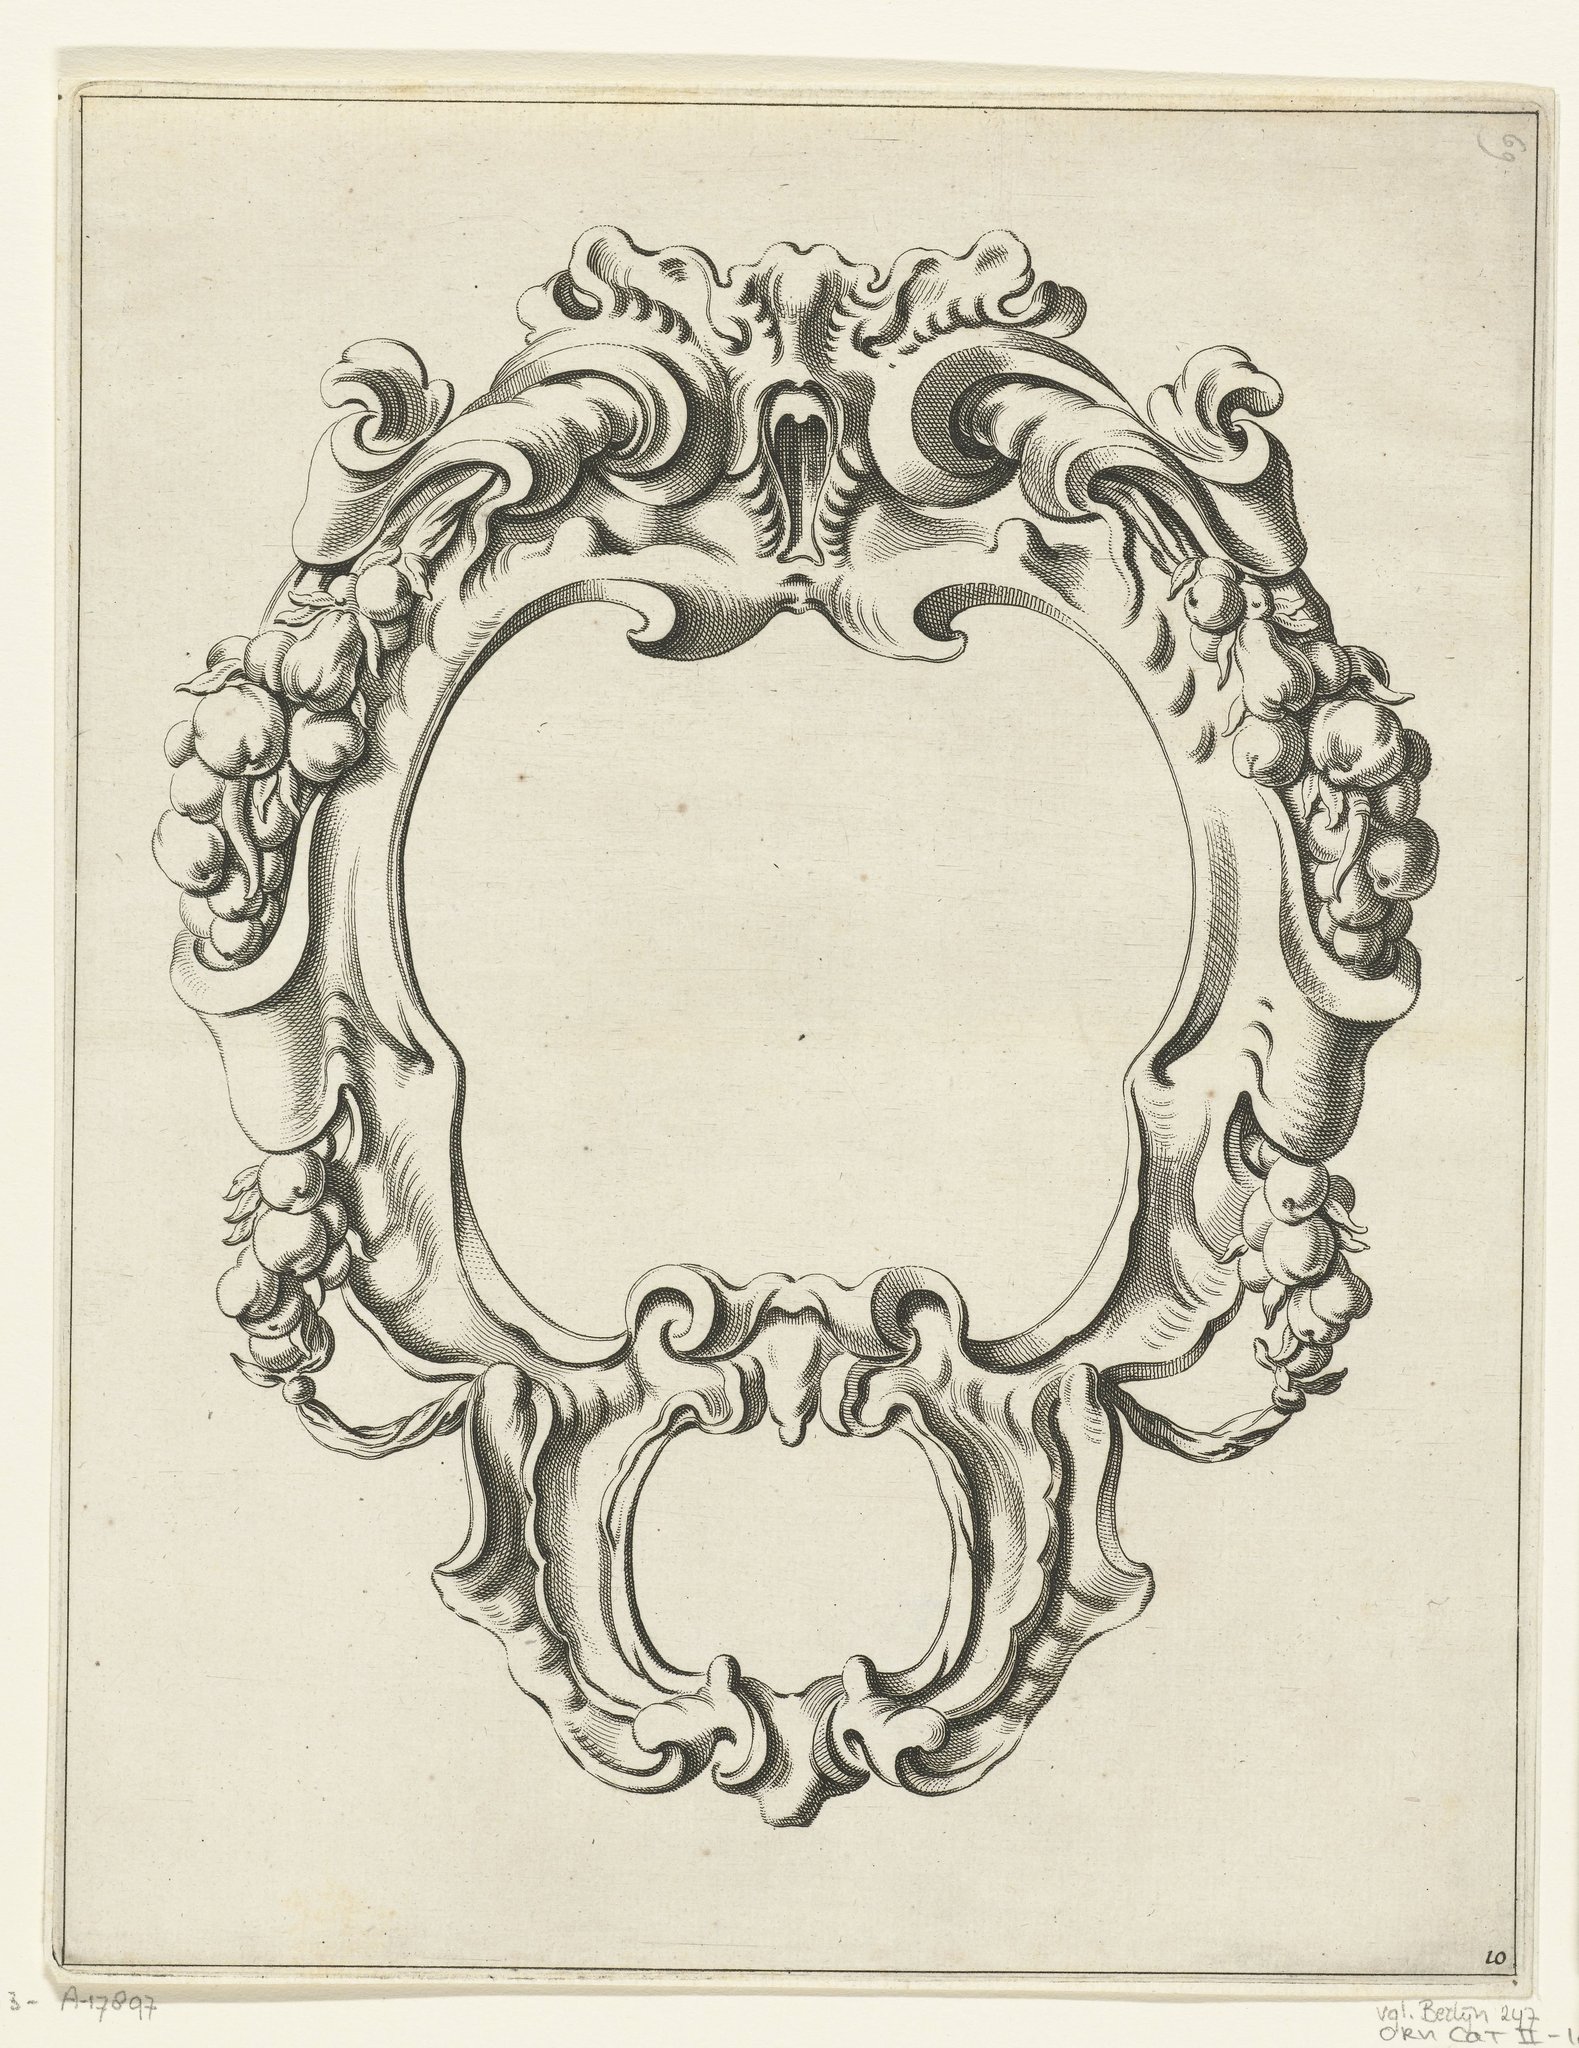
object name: ornament print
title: Cartouche met kwabornament bestaande uit twee compartimenten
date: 1655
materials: paper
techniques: etching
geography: netherlands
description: Bovenaan is een masker te zien en aan de zijkanten hangen twee guirlandes met fruit.